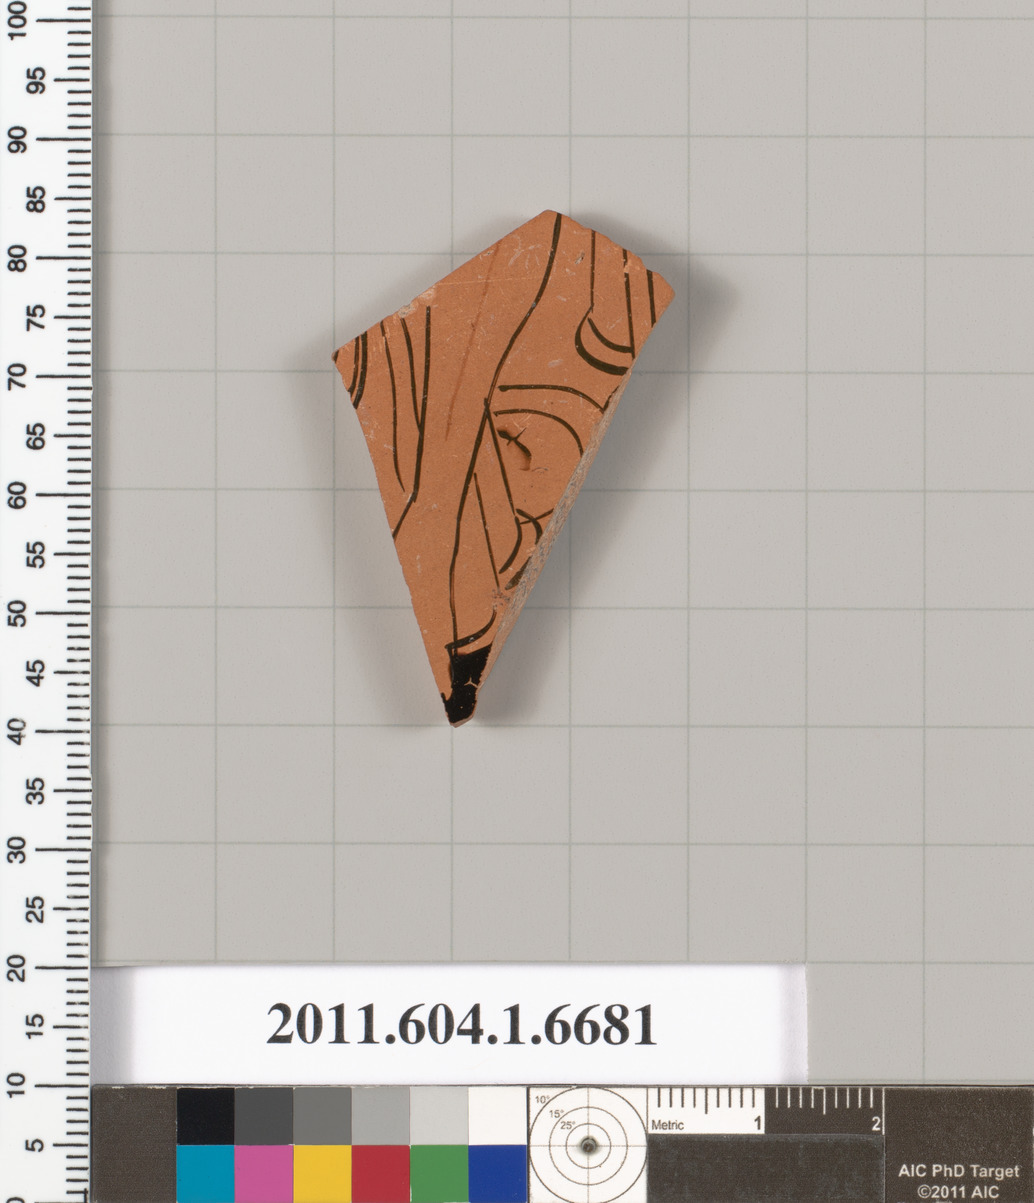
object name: kylix fragment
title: Terracotta fragment of a kylix (drinking cup)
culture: greek, attic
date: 490-470 BCE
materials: terracotta